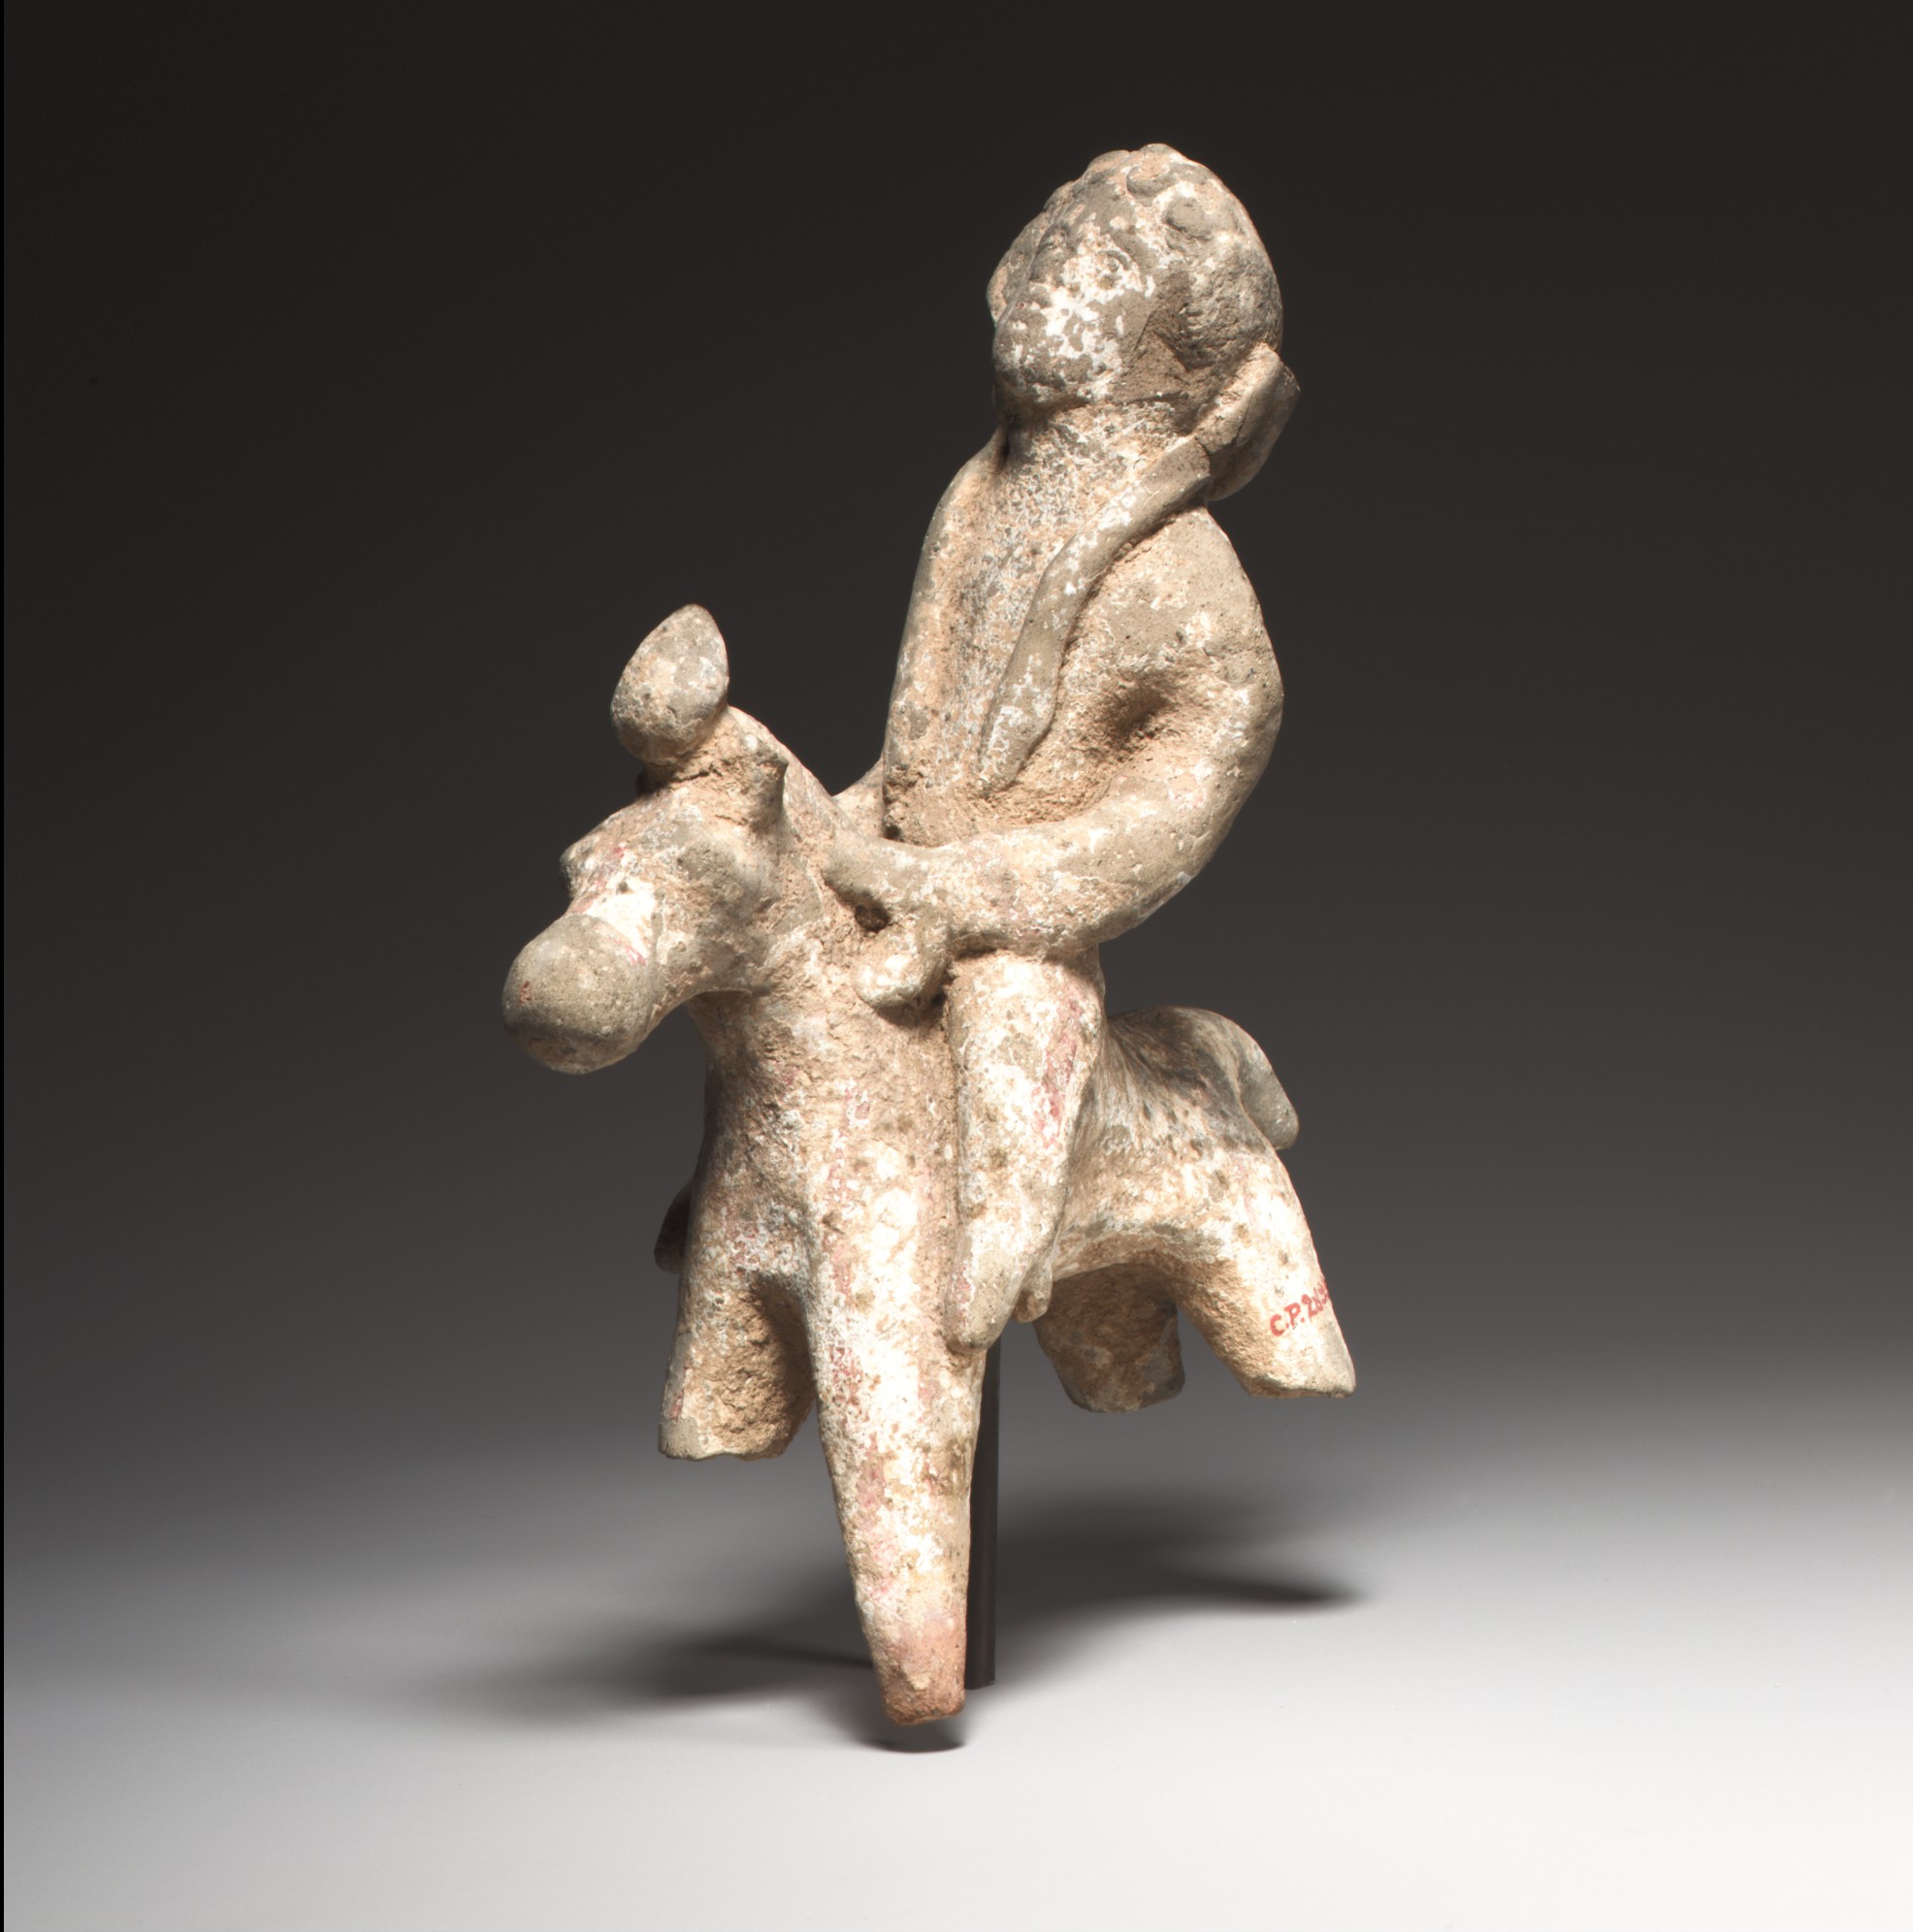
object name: statuette of a warrior on horse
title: Horse and rider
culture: cypriot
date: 400-201 BCE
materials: terracotta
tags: human figures,horses